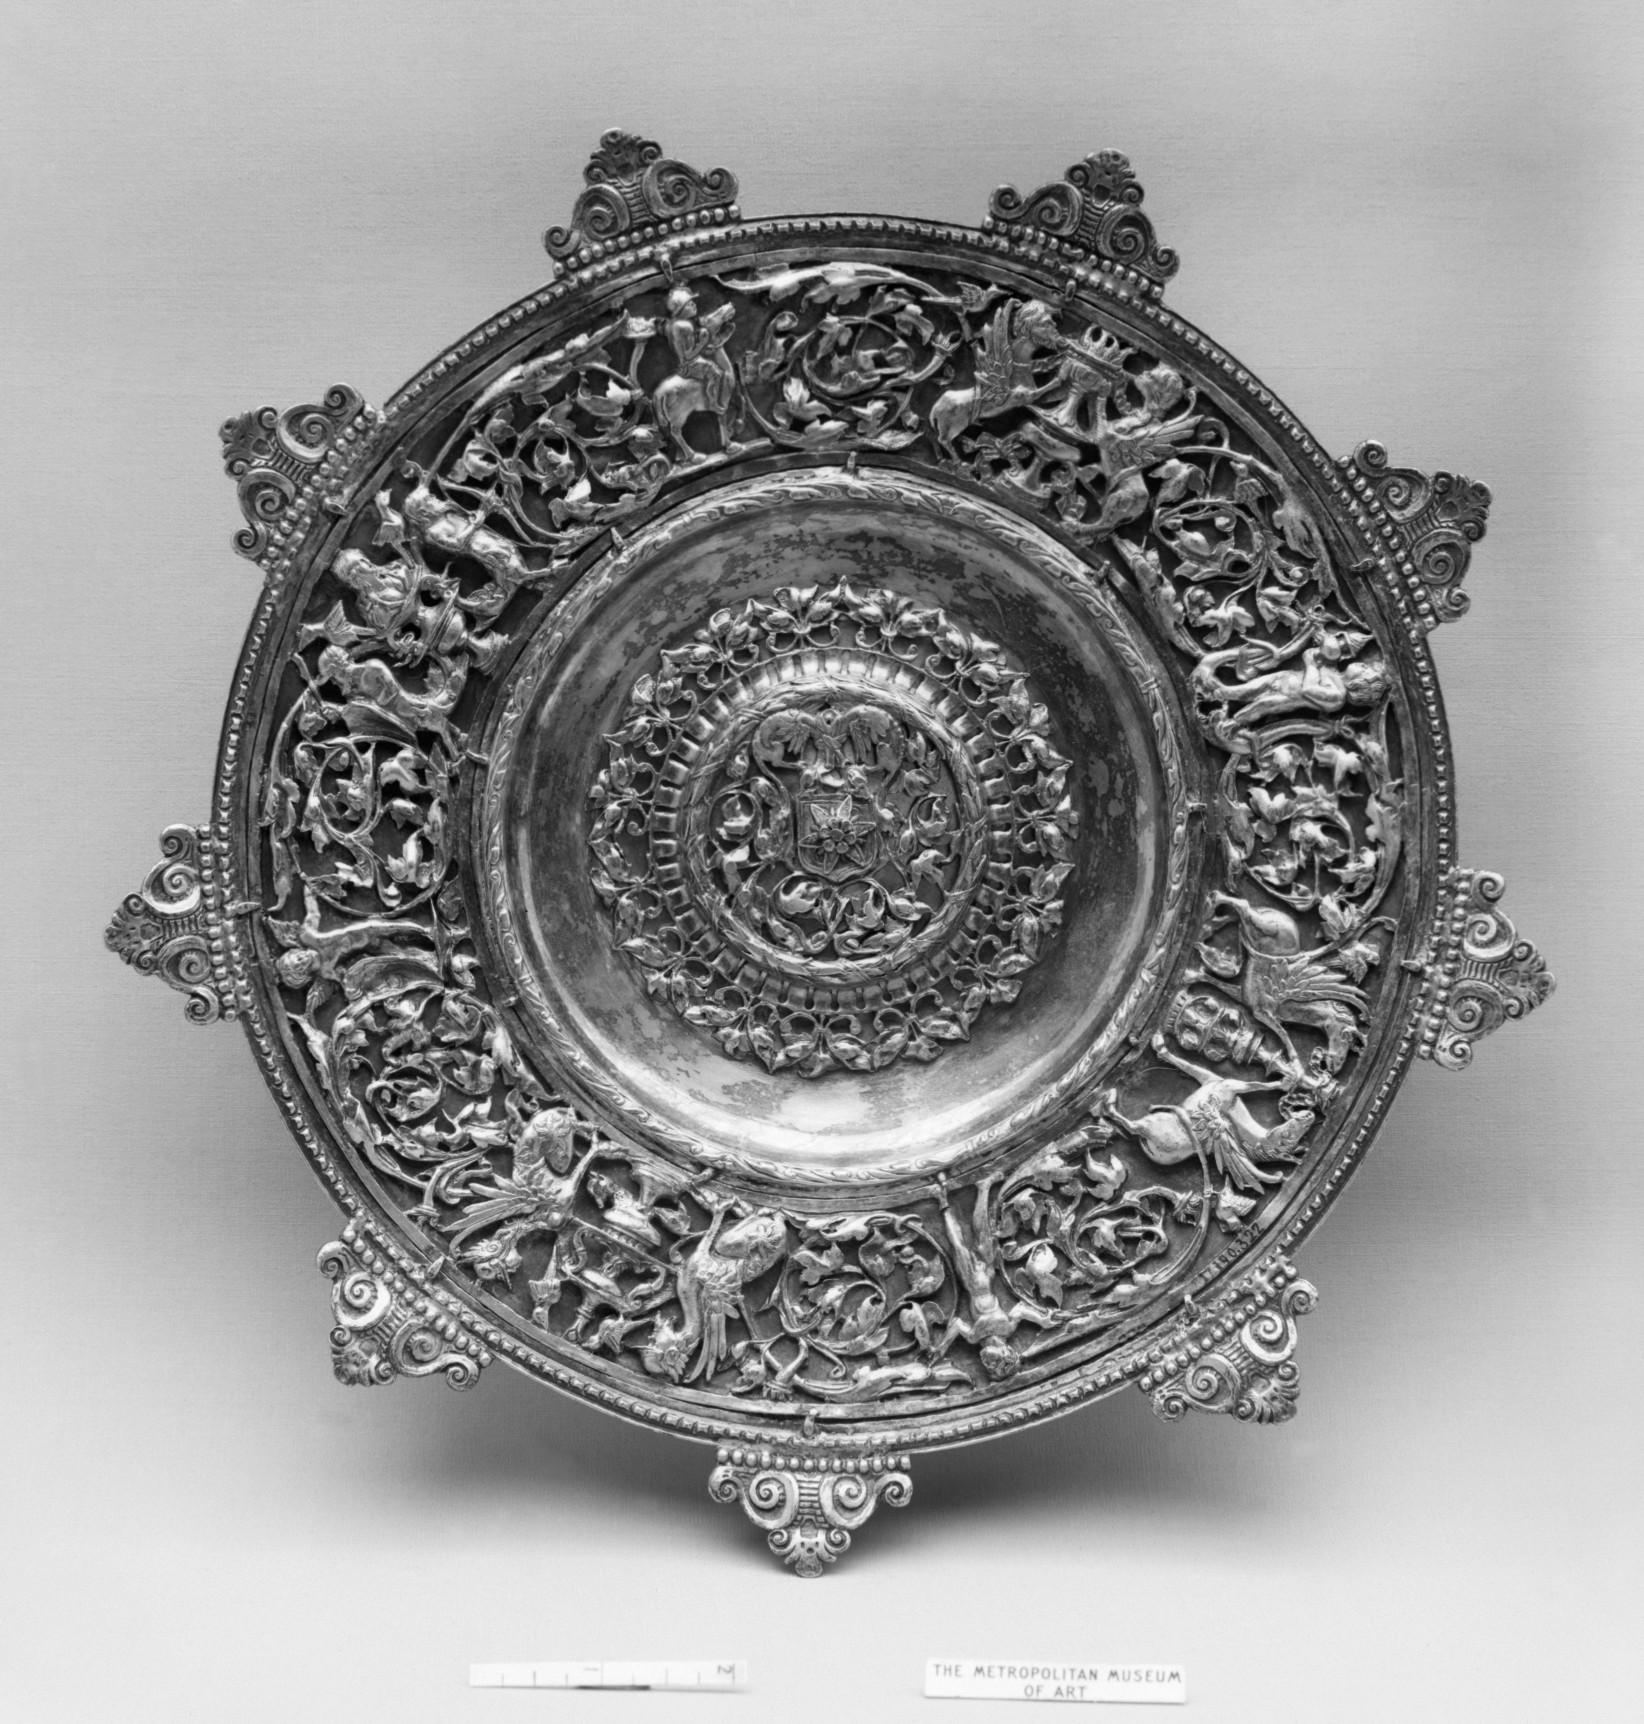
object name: plateau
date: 1501-1600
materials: gilt, silver